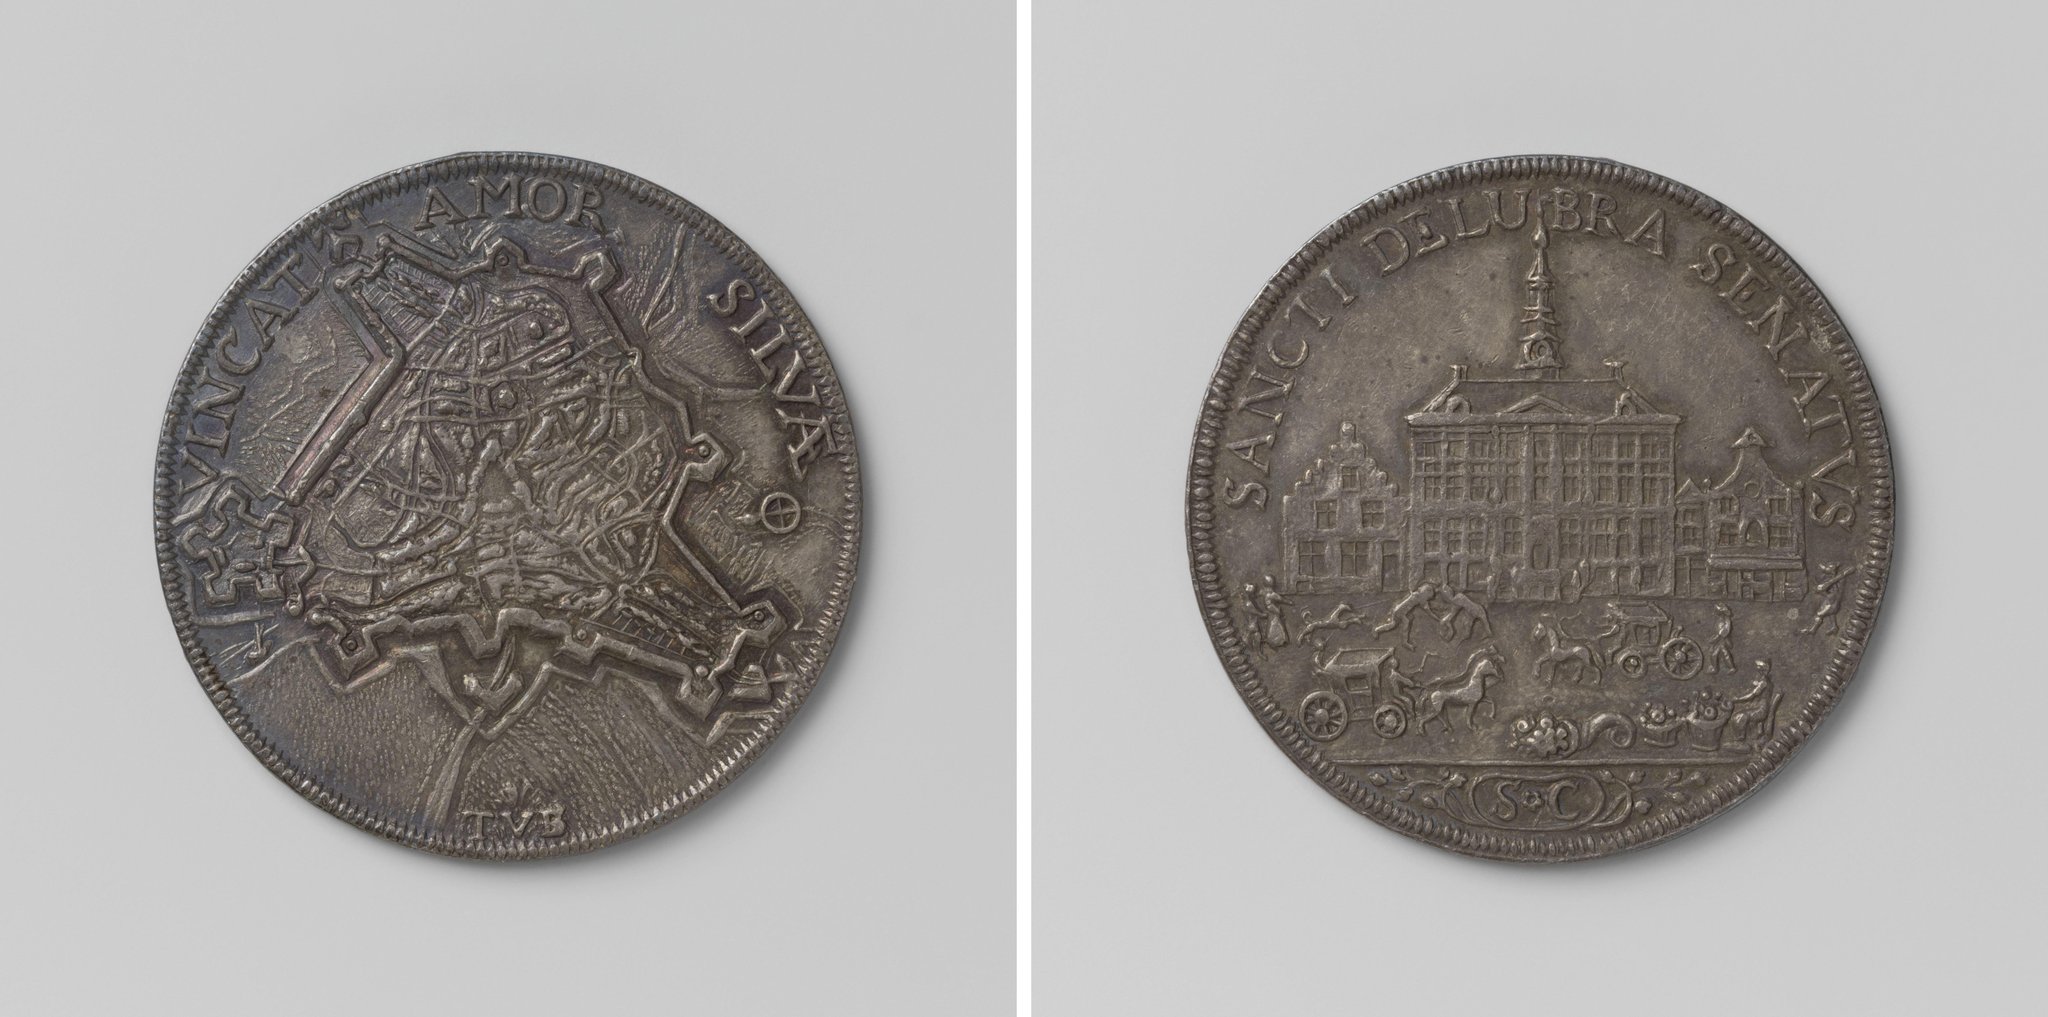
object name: council medal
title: Vroedschapspenning van de stad 's-Hertogenbosch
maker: theodorus casparus van berckel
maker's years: 1680-1734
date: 1726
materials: silver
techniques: striking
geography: den bosch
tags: den bosch